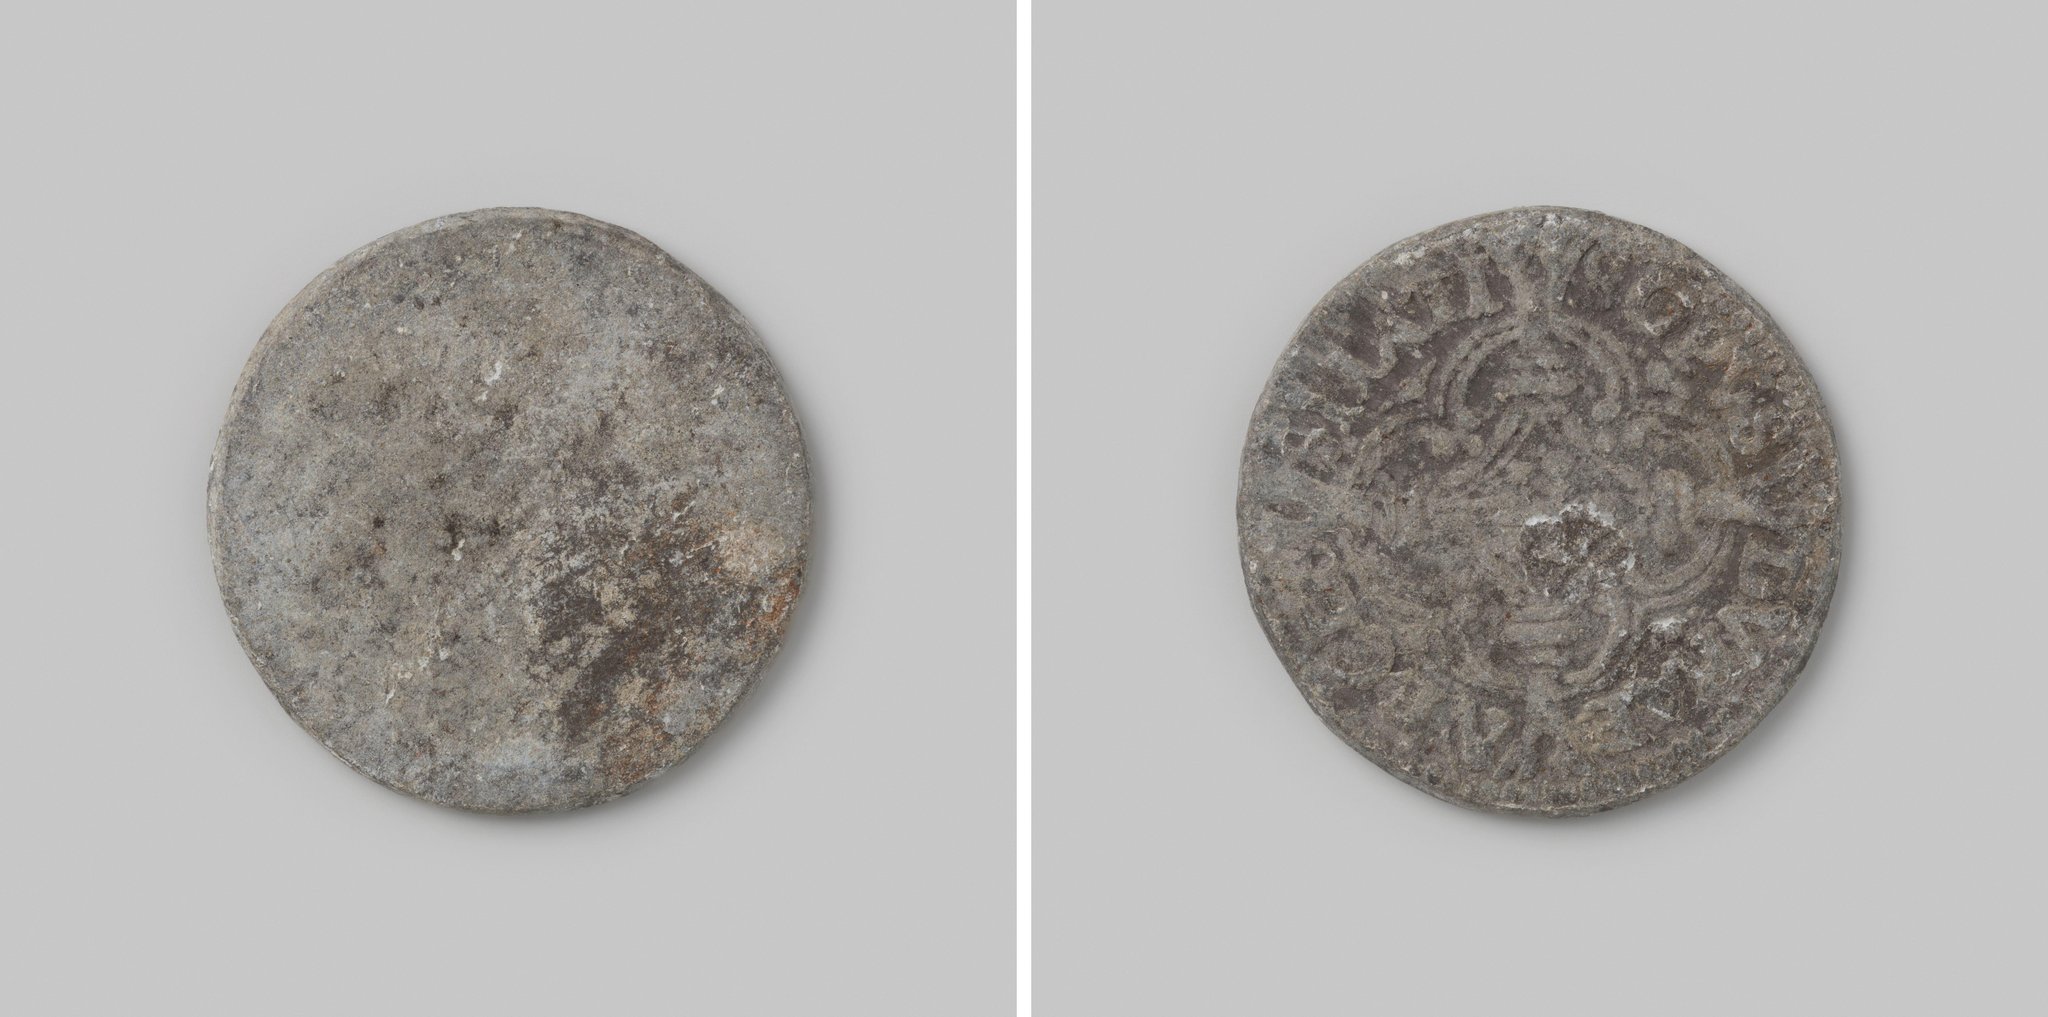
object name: coin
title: Stad Zaltbommel, stuiver. Afslag in lood van de keerzijde.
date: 1579-1582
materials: lead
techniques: striking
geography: zaltbommel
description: Loden afslag van een zilveren munt. Keerzijde: vierpas, waarop lang gelelied kruis met in het midden een omhoog stekend zwaard met aan weerzijden daarvan een rozet. Linksonder beginnend omschrift: DVRAE -NECES-SITATI-S OPVS. Afslag in lood van de keerzijde, vervaardigd met in Zaltbommel nog aanwezig stempel.